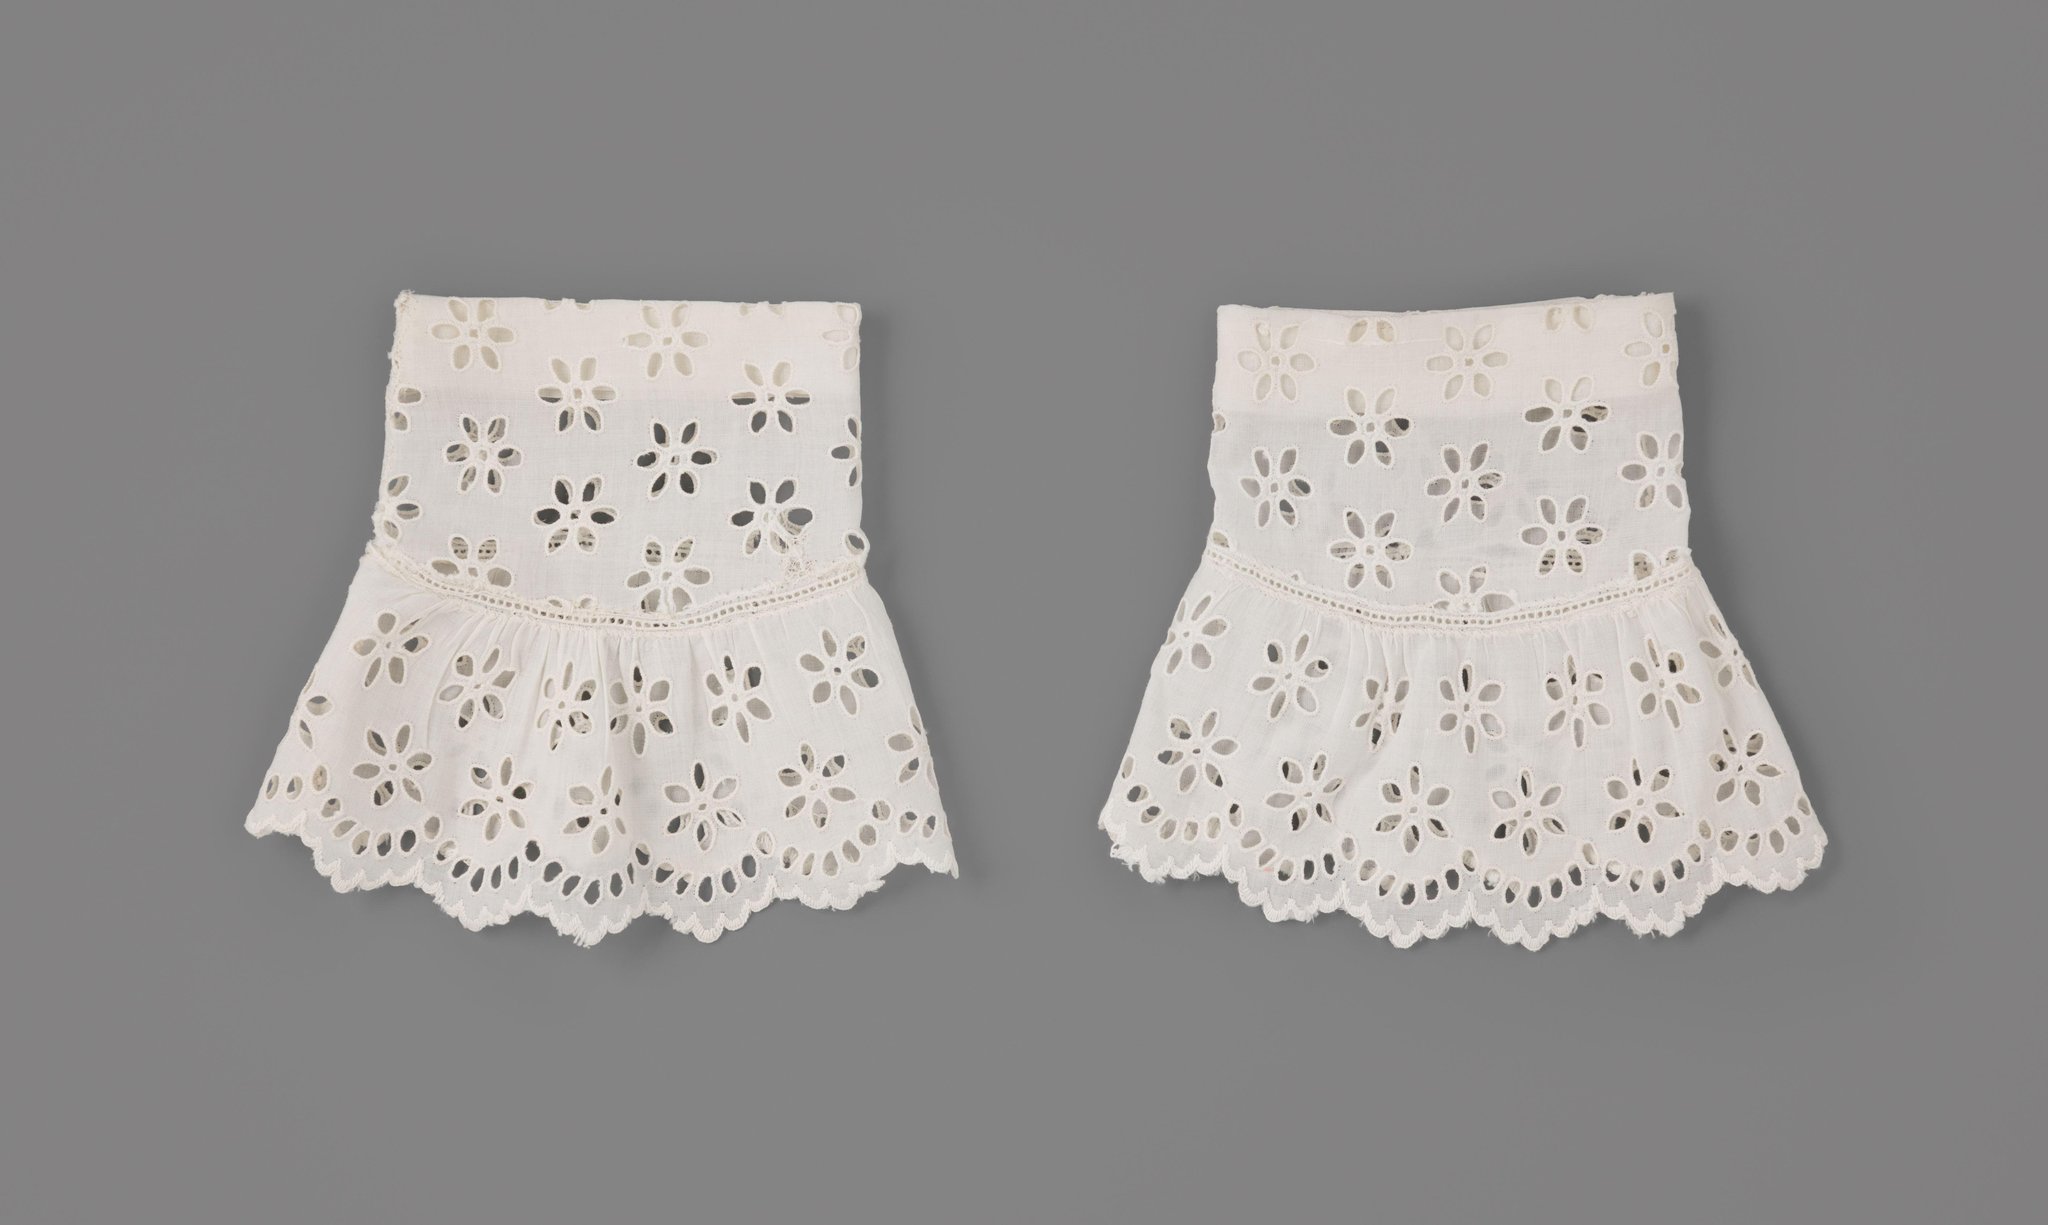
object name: cuff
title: Manchet van batist, versierd met Engels borduurwerk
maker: Anonymous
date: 1875-1925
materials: textile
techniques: english embroidery, festoon stitch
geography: western europe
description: Manchet van batist, afgezet met een aangerimpelde strook met gefestonneerde schulprand. Zowel de manchet, als de strook zijn versierd met Engels borduurwerk.